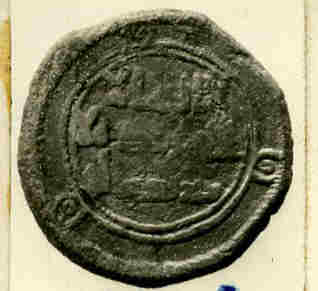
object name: coin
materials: copper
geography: iran